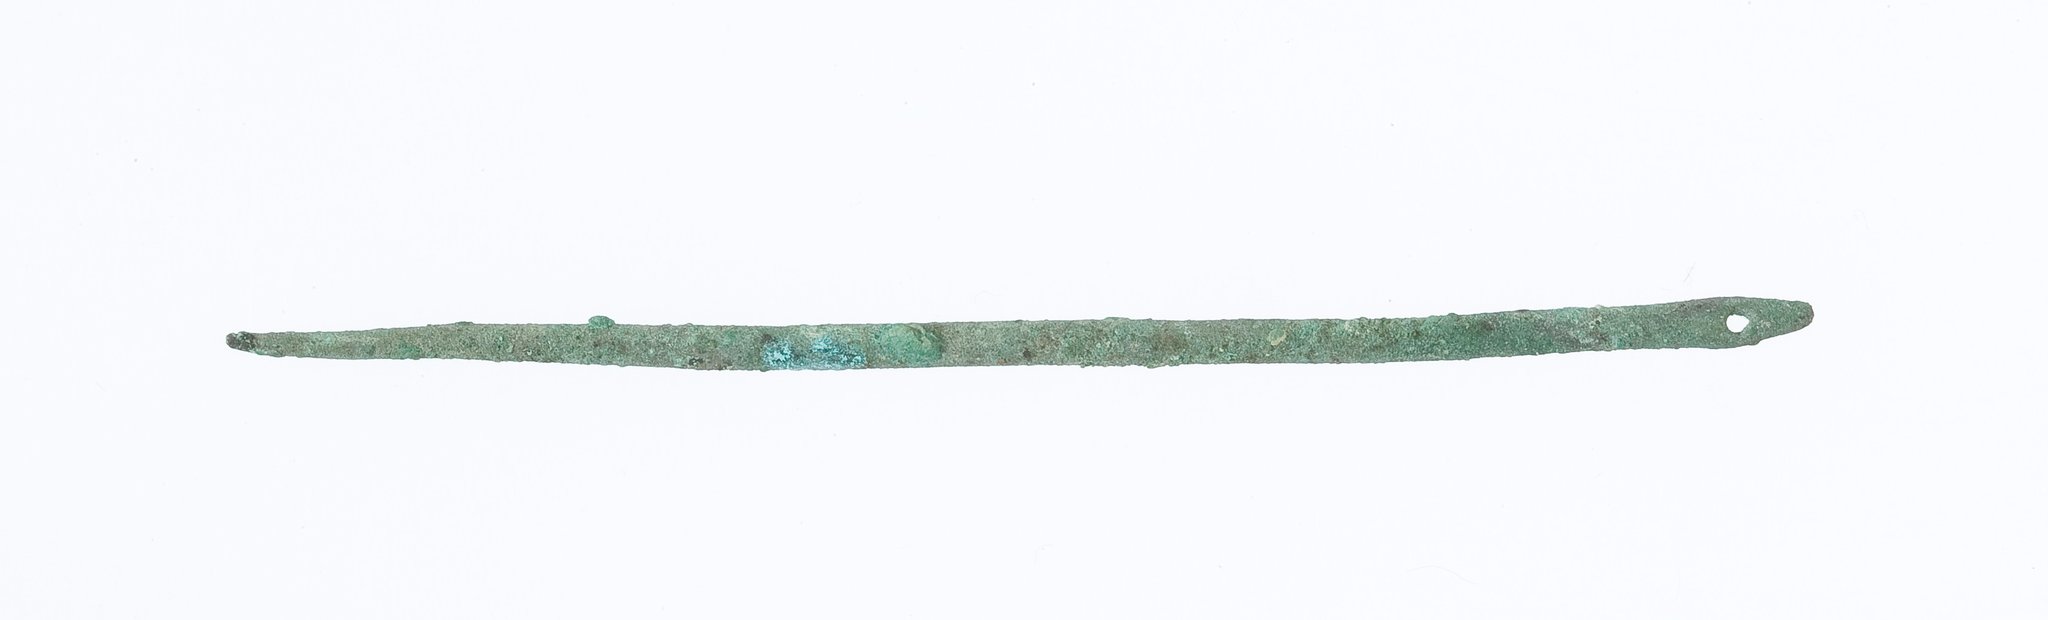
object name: needle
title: Textile manufacturing tool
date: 1295-1070 BCE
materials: bronze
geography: egypt